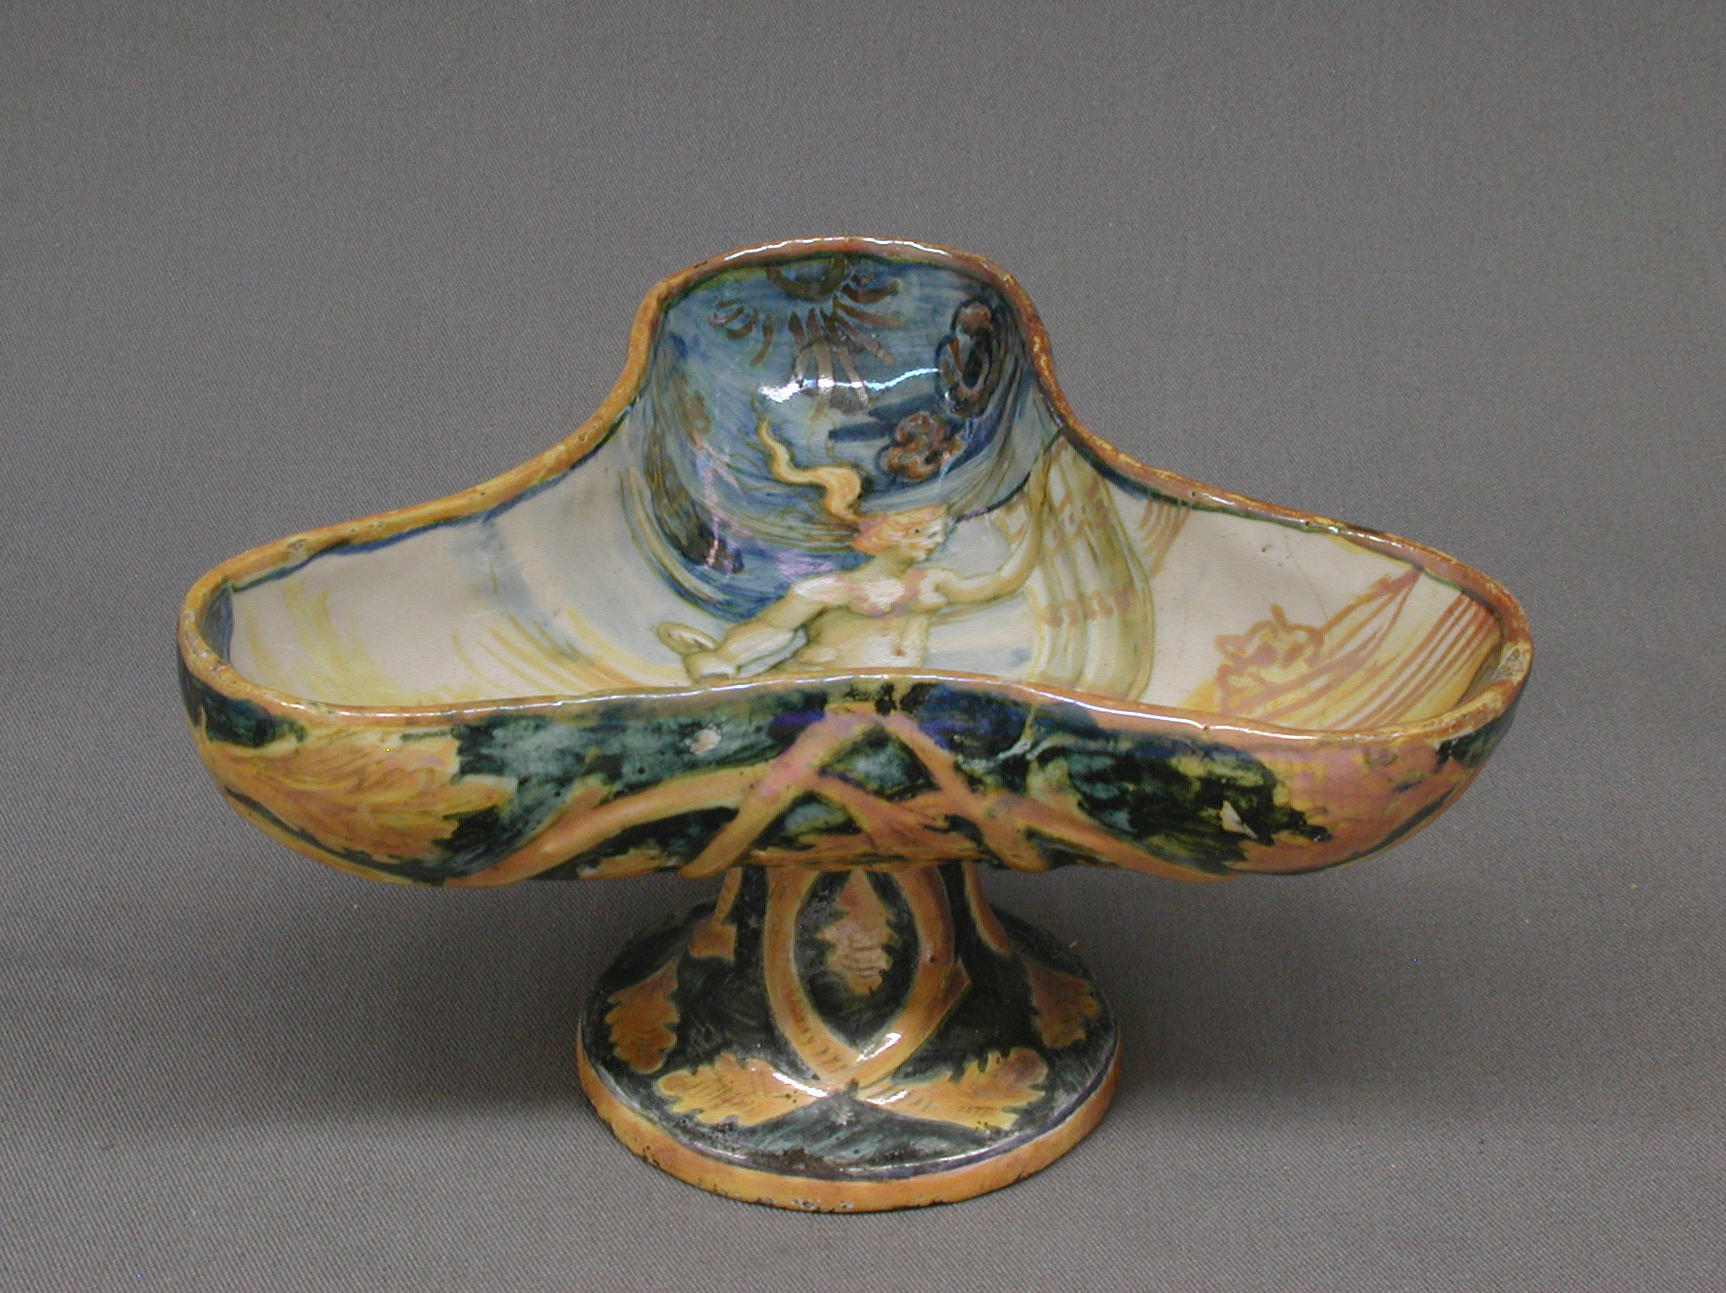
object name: trilobed vessel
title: Trilobed vessel with figure of Fortuna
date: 1535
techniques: maiolica, glazing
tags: human figures